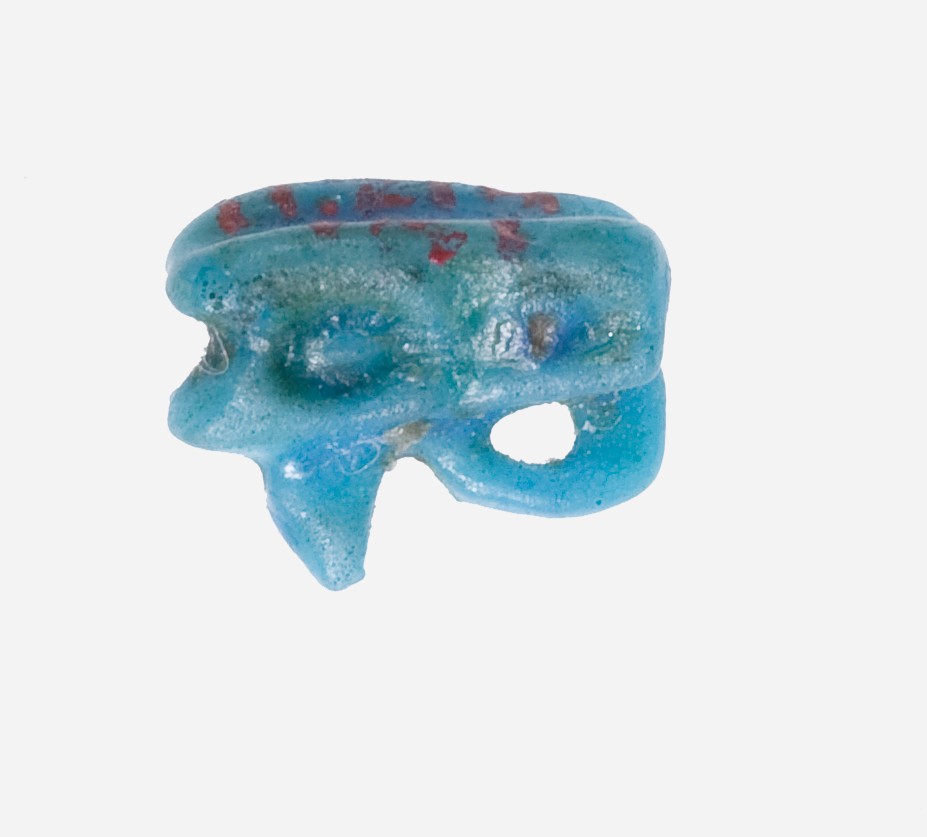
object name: amulet, wedjat eye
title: Wedjat Eye Amulet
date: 1390-1352 BCE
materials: faience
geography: egypt